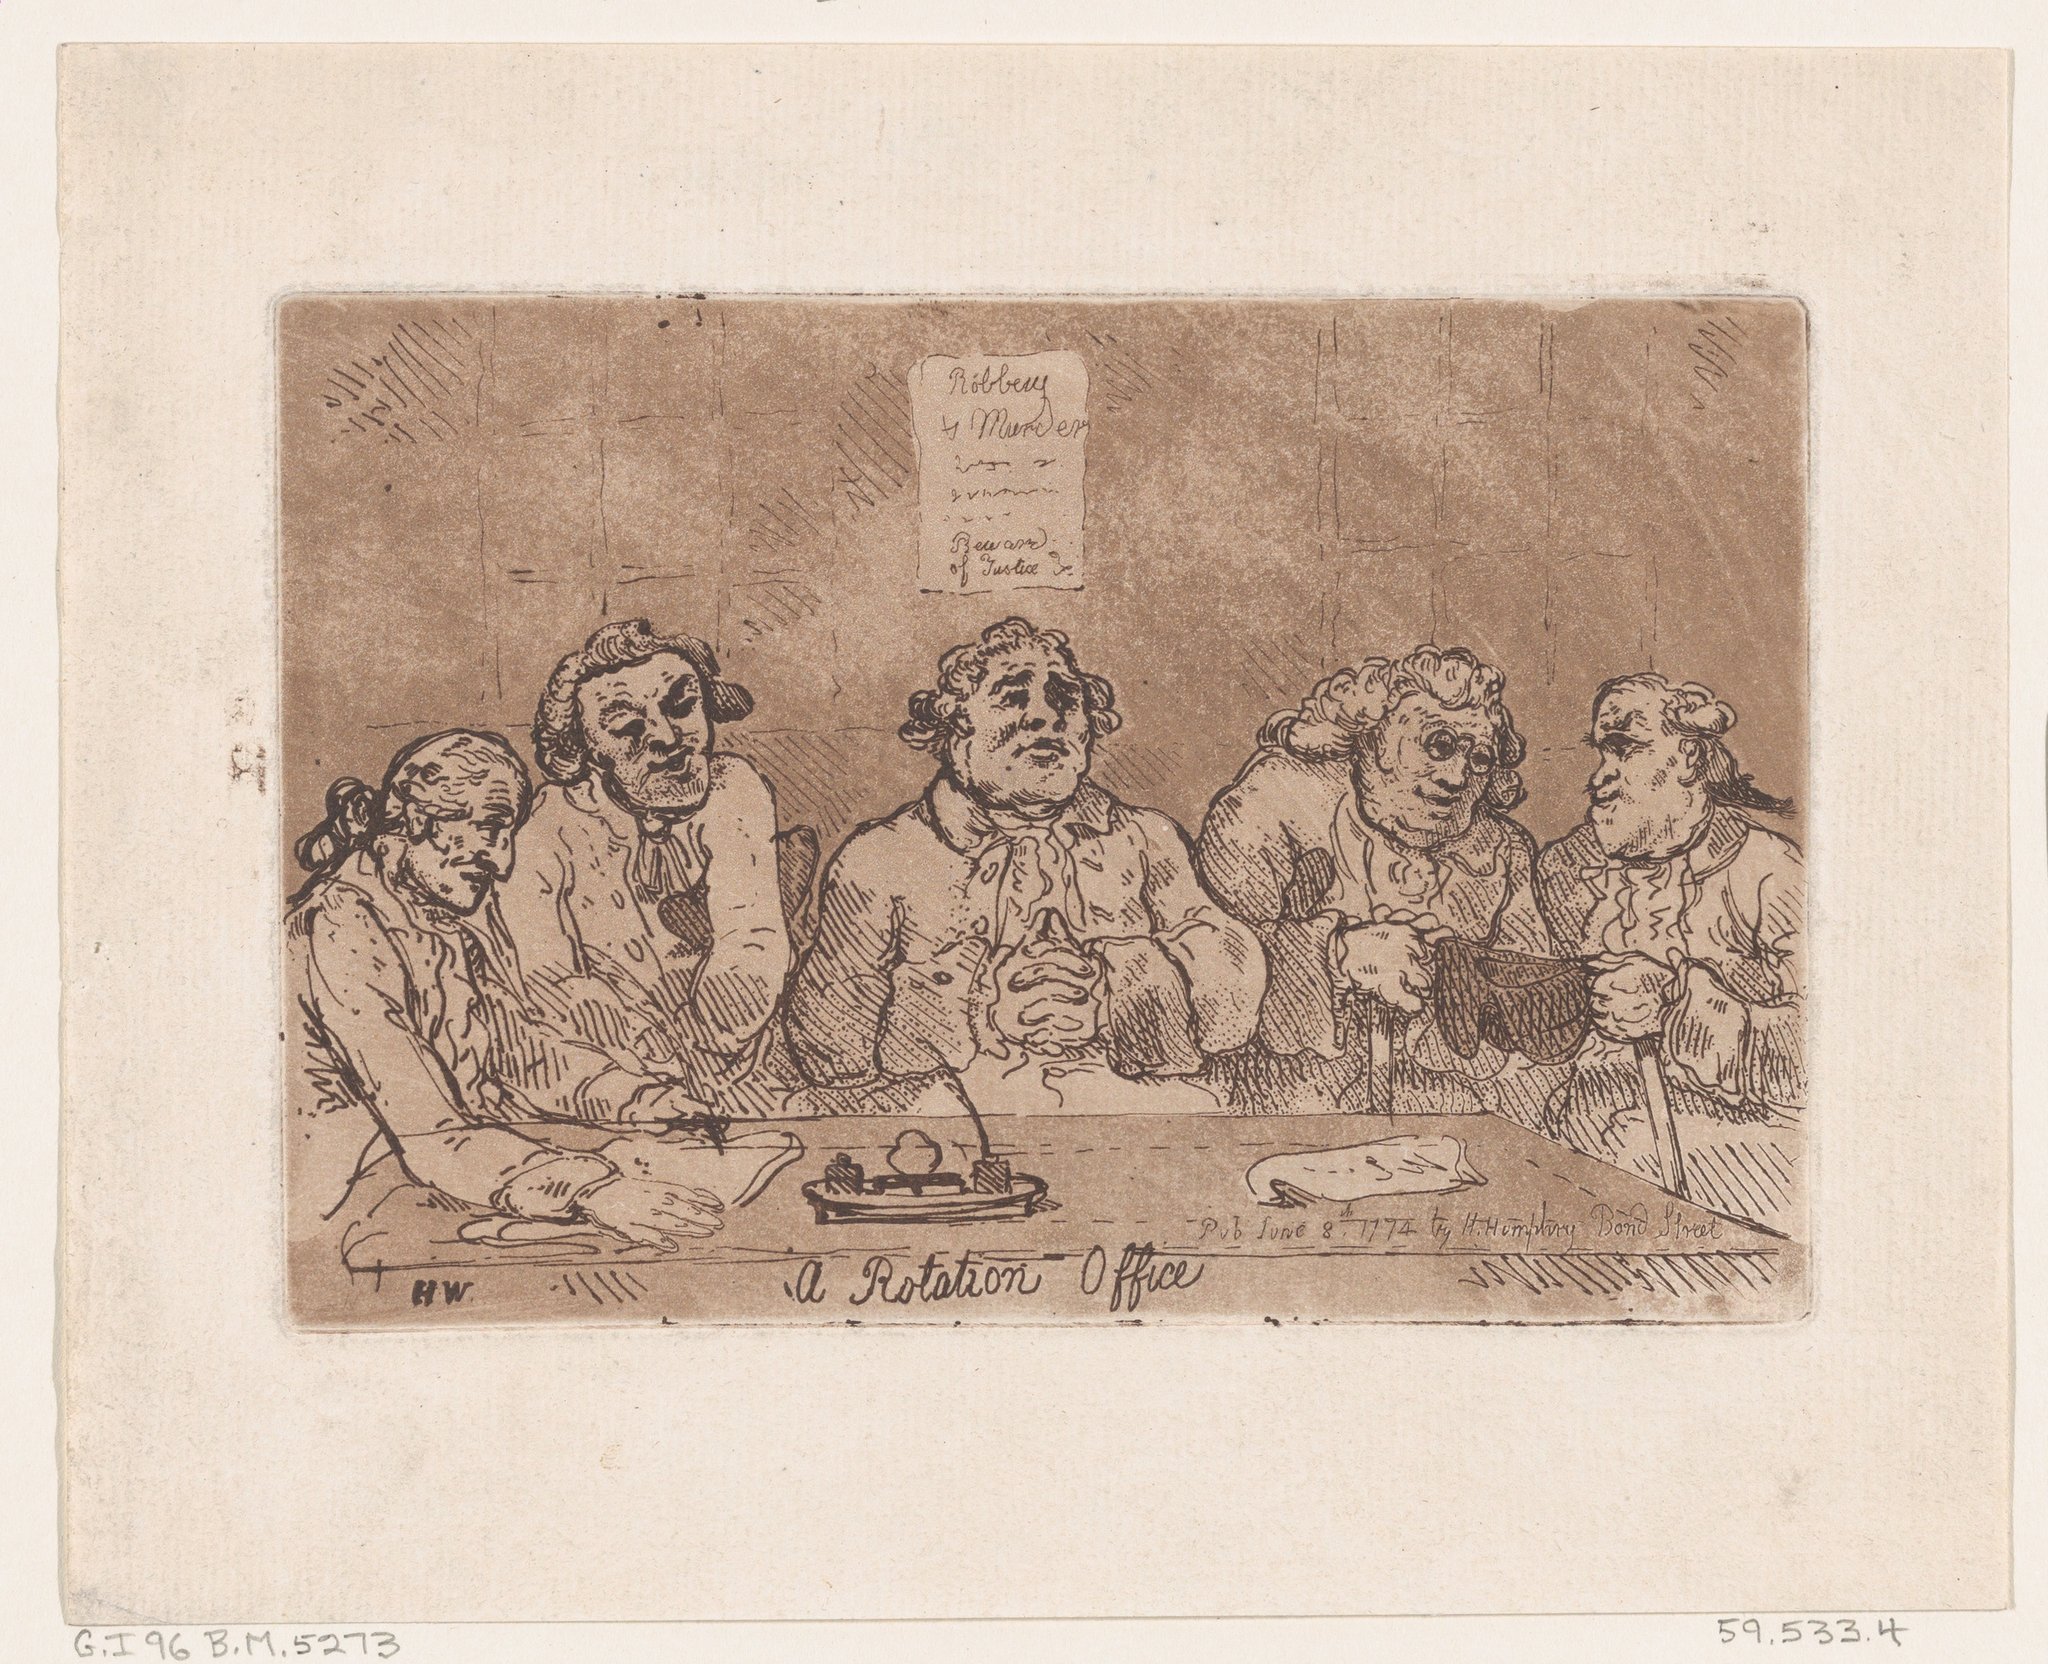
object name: print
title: A Rotation Office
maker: thomas rowlandson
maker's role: artist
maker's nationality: british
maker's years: 1757-1827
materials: ink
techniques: aquatint, etching, printing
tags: satire,men